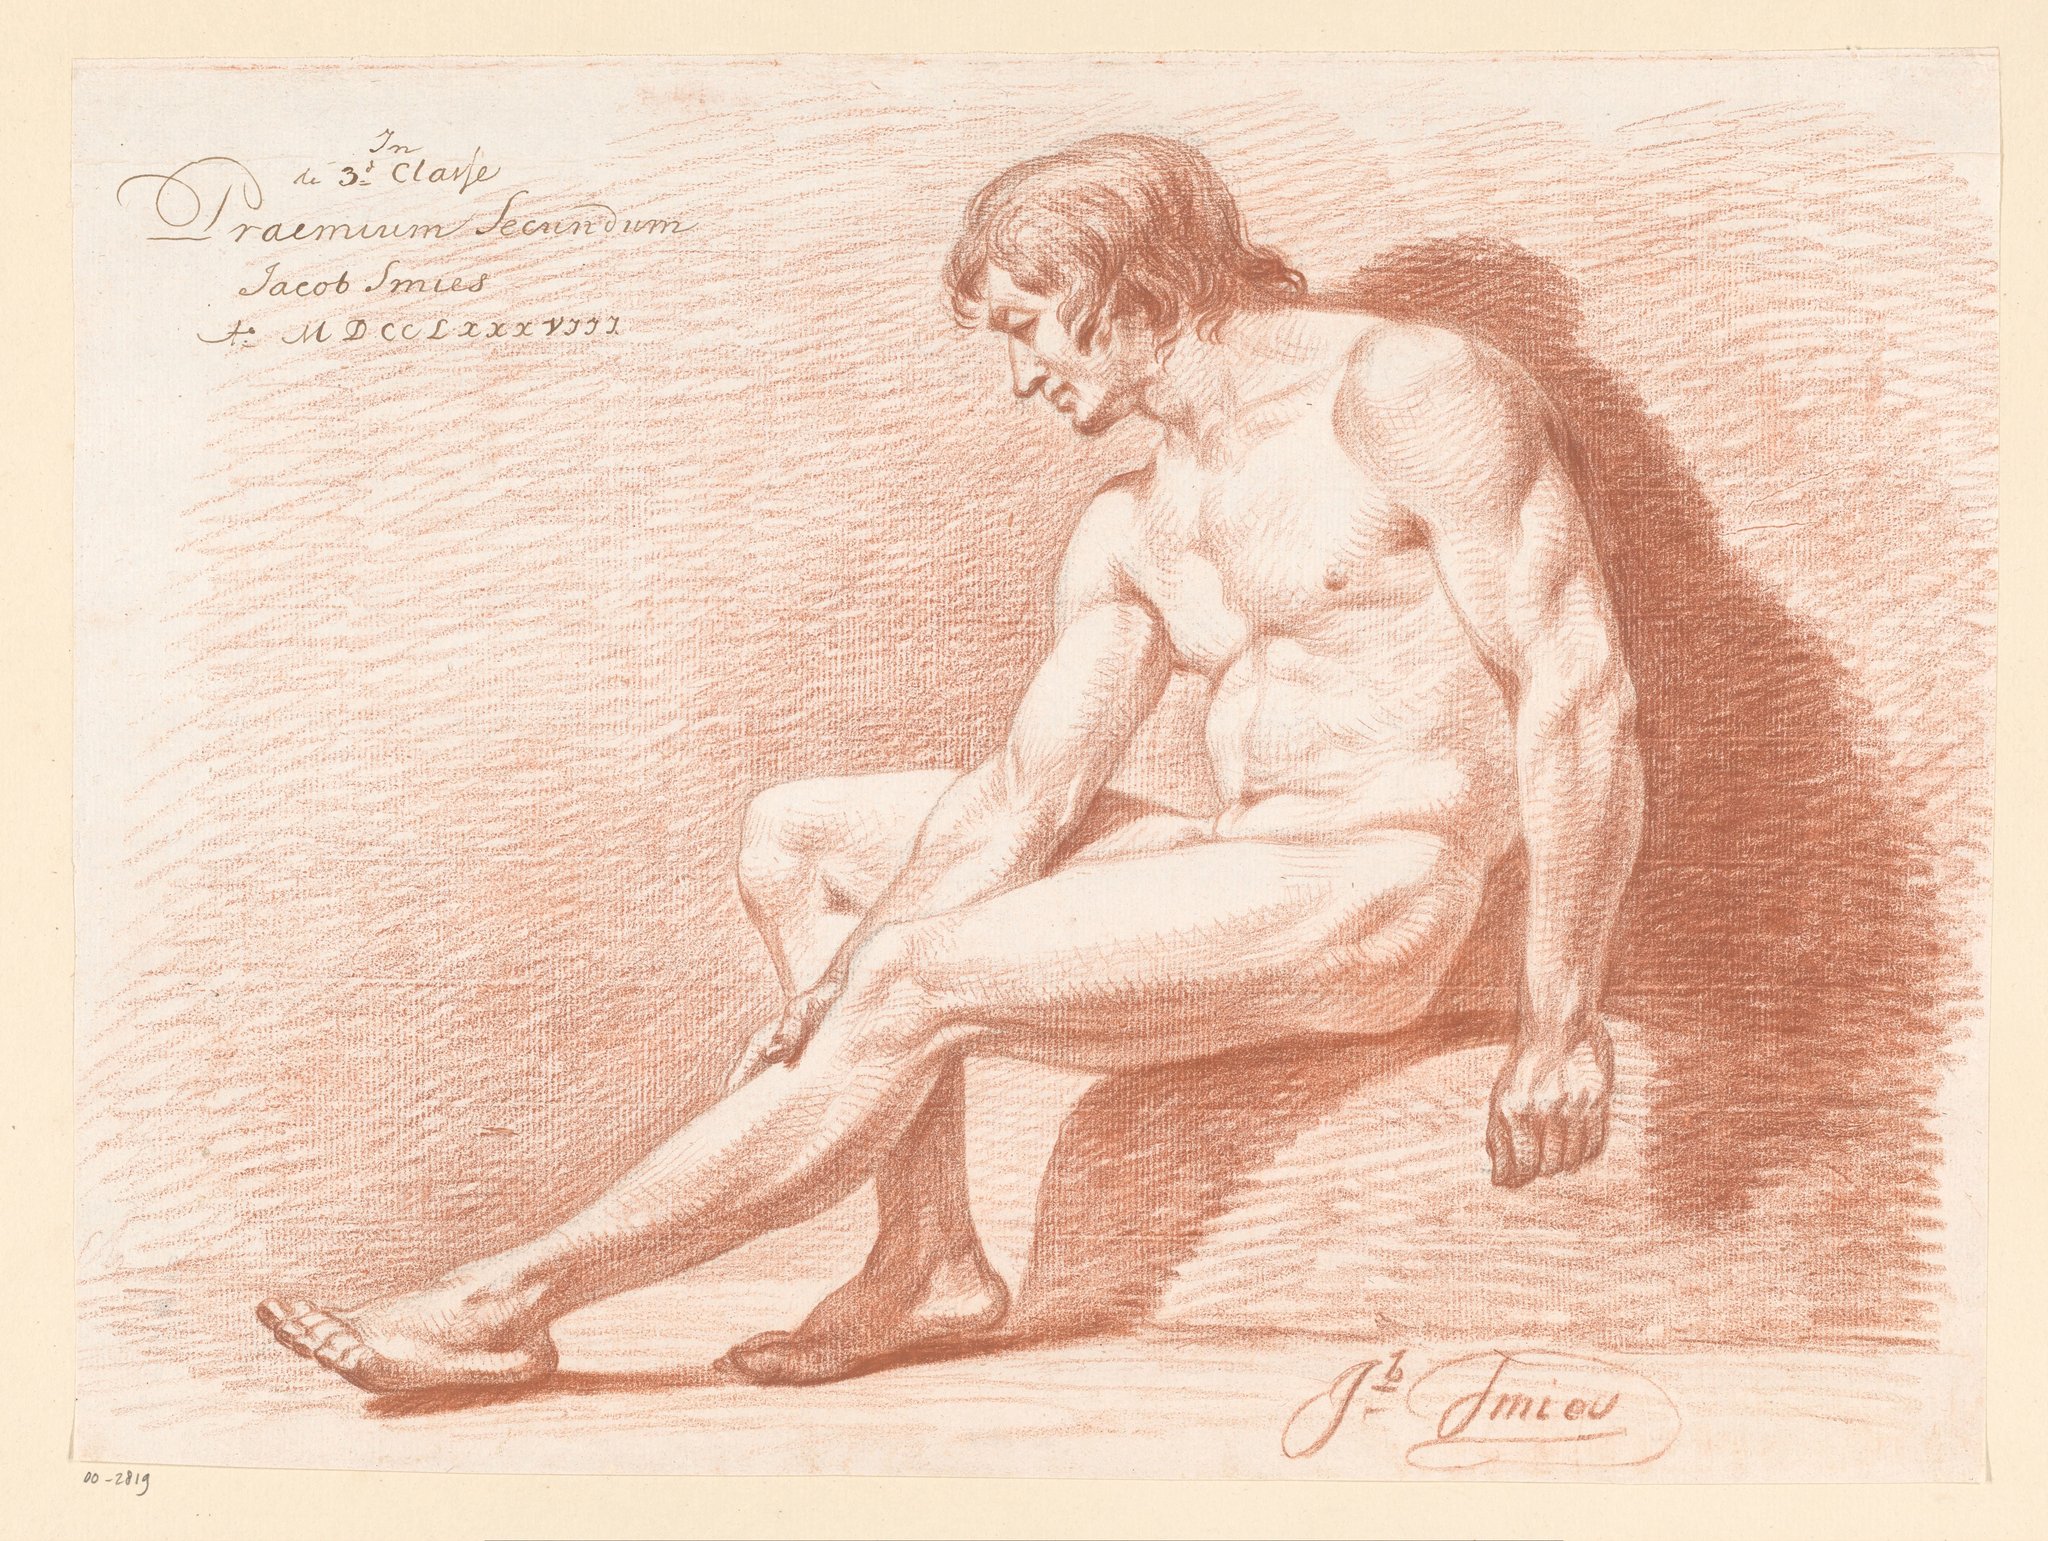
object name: drawing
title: Zittend mannelijk naakt, van opzij gezien (2e prijs 1788)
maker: jacob smies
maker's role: draughtsman, painter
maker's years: 1746-1833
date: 1788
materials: chalk, charcoal, paper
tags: sitting figure (+ nude human being)